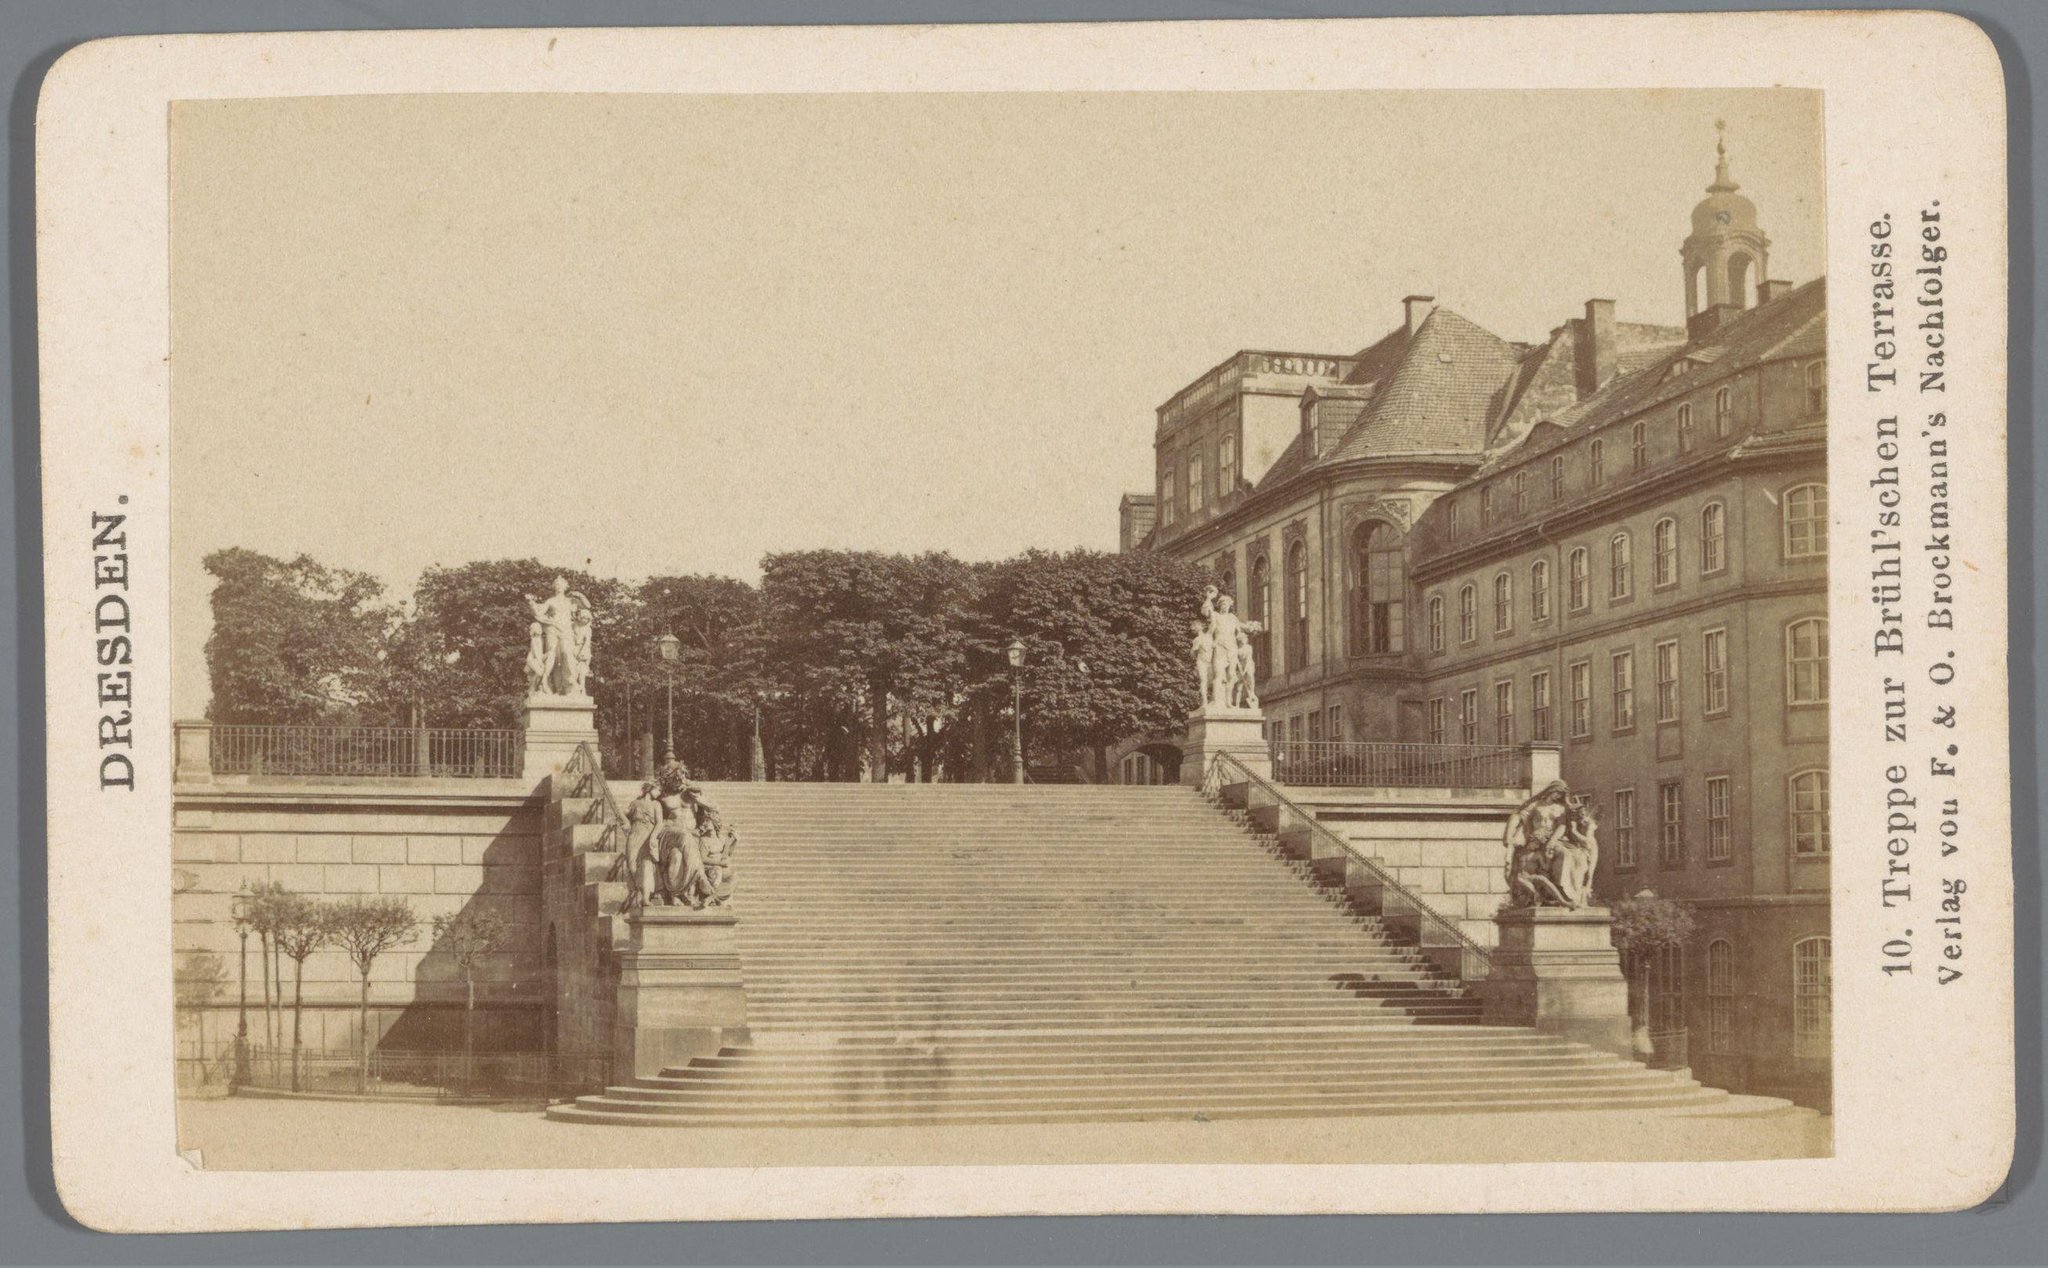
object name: carte de visite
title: Trappen van de Brühlsche Terrasse in Dresden met de Vier Tageszeiten naar Johannes Schilling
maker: Anonymous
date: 1860-1875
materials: cardboard, paper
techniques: albumen print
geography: dresden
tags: monument, statue, terrace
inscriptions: number: ‘10.’